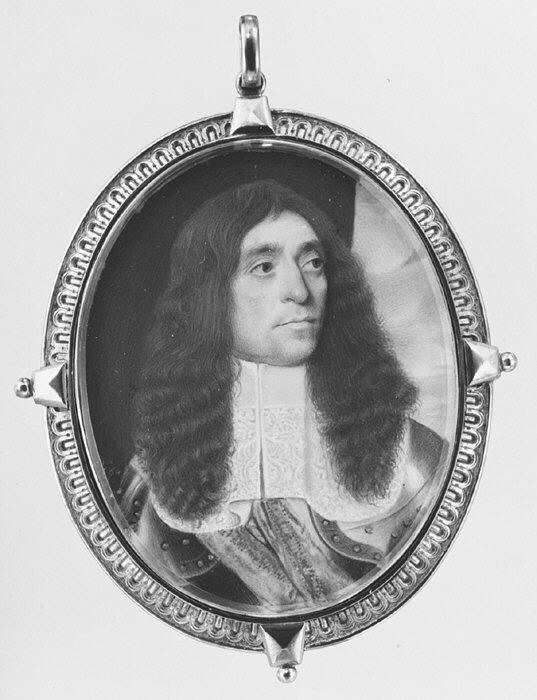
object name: painting, miniature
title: Portrait of a Man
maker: david myers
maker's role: artist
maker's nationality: british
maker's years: 1659-1676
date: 1664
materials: parchment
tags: men,portraits